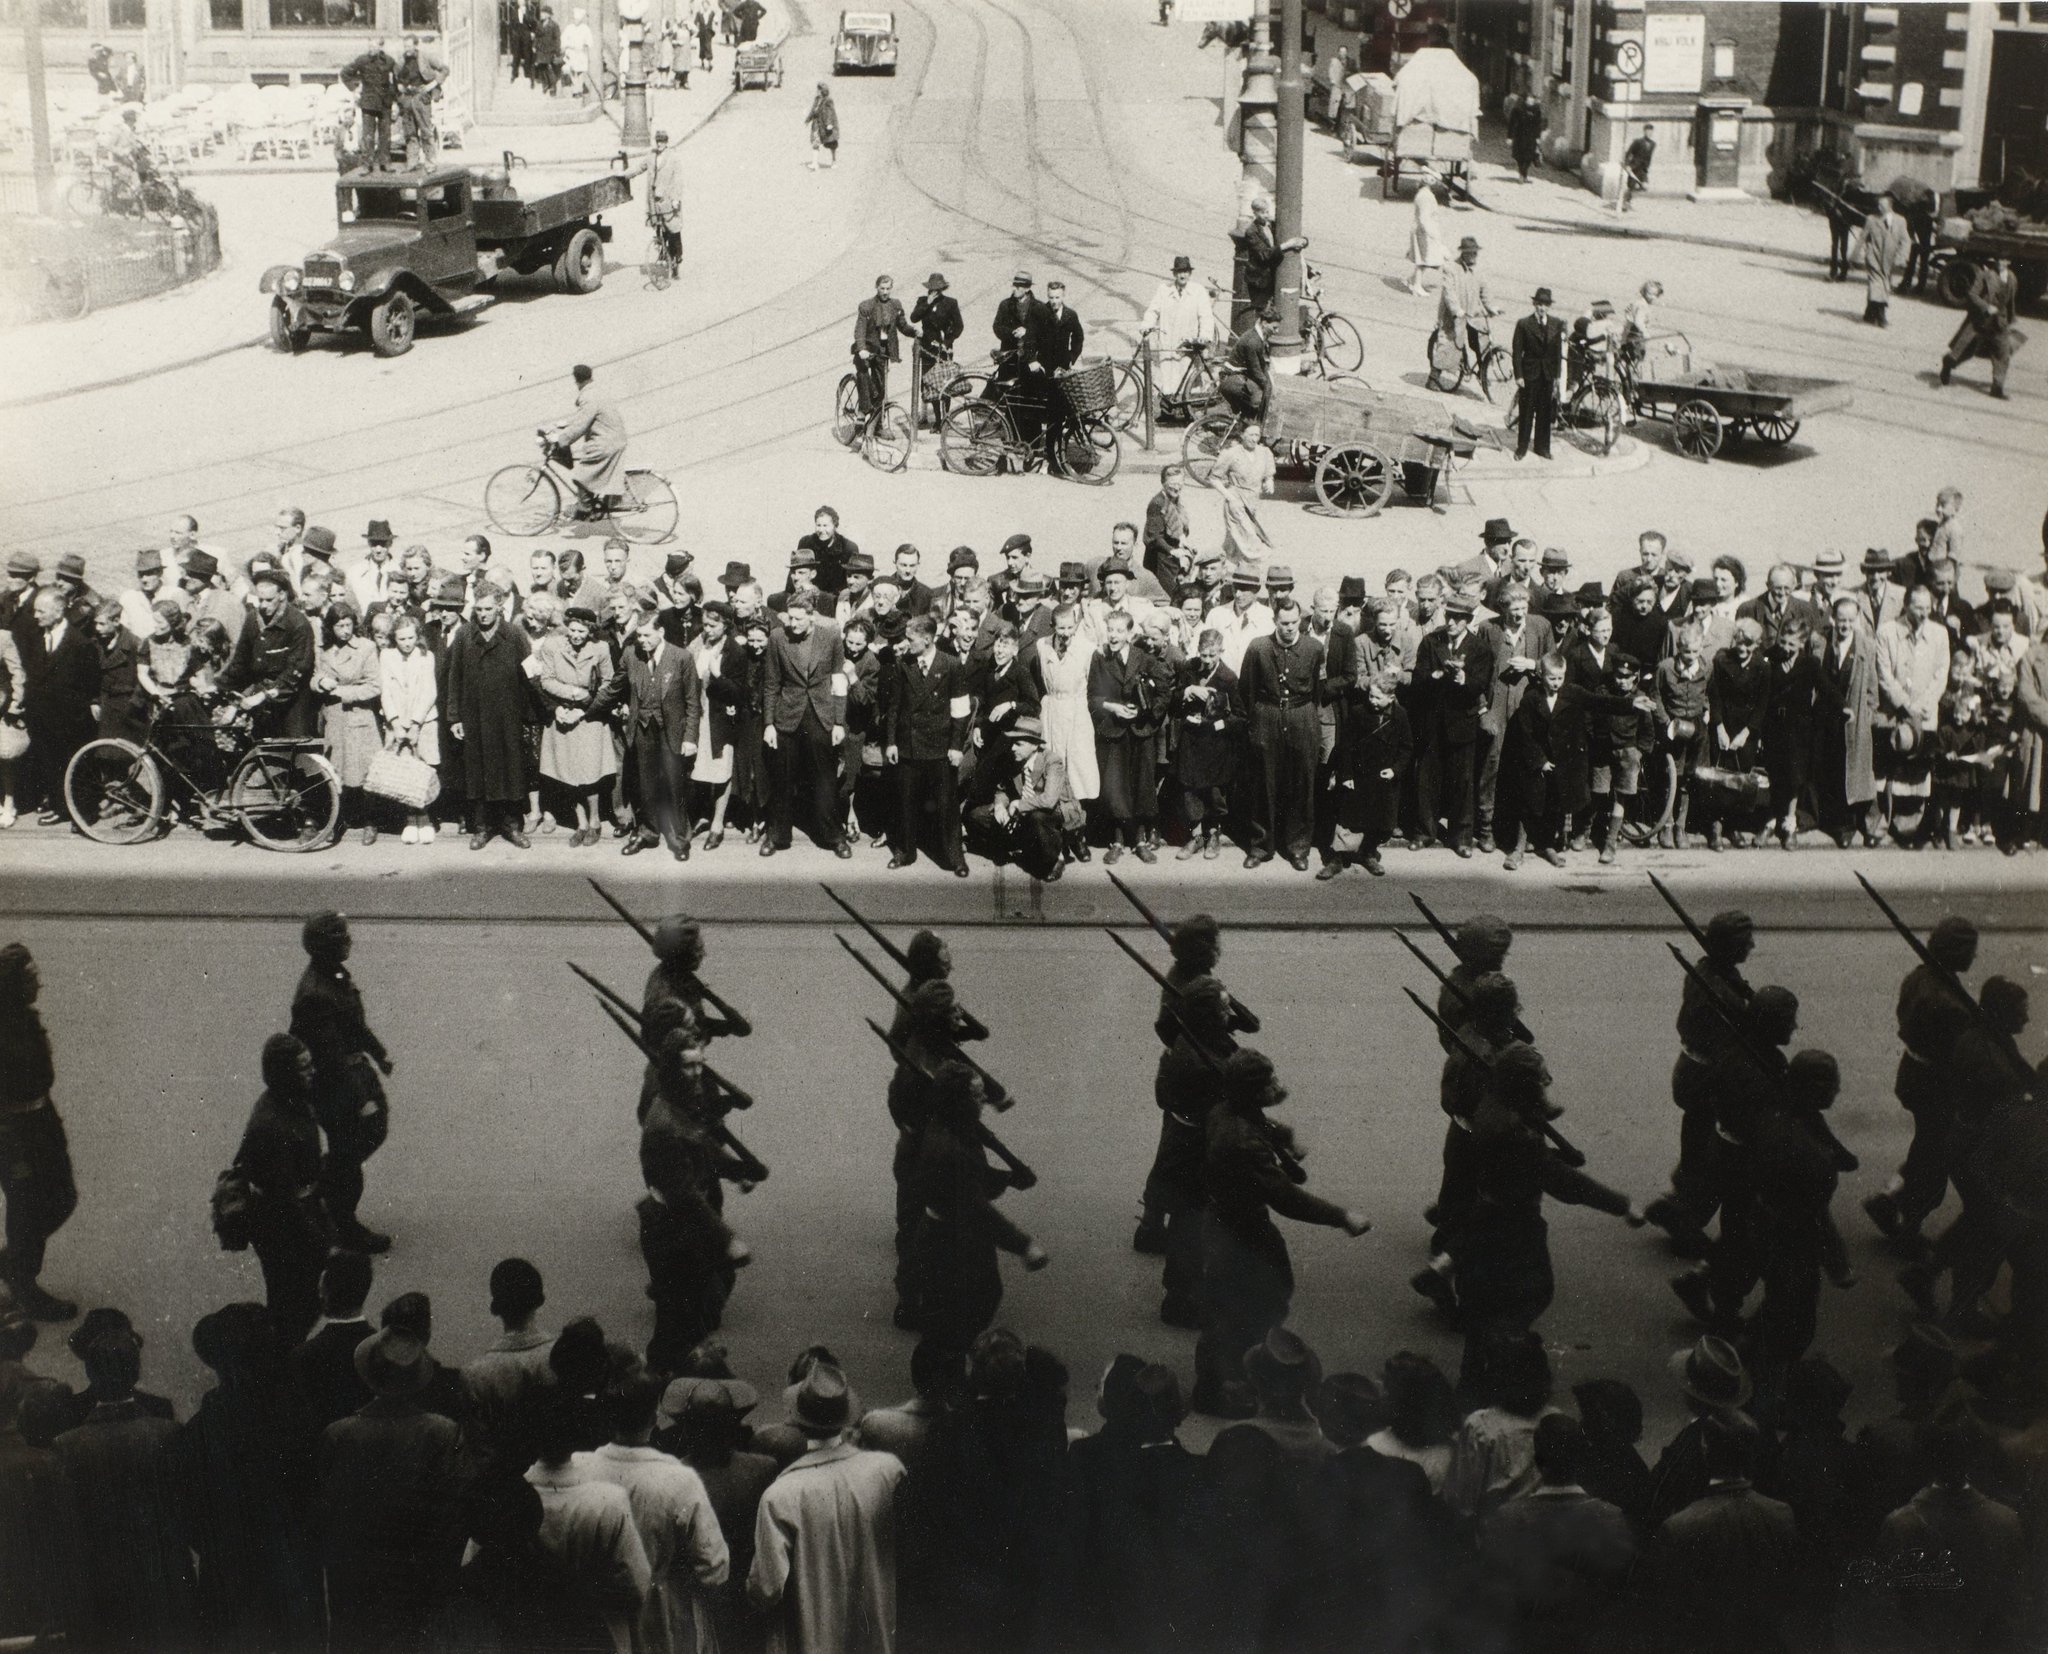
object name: photograph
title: Canadese militairen op het Leidseplein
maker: jacob merkelbach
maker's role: fotograaf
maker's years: 1877-1942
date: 1906-1945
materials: paper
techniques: photography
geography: amsterdam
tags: amsterdam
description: Naar rechts langstrekkende colonne van Canadese militairen te midden van publiek, op het Leidseplein te Amsterdam; foto vanuit Hirsch-gebouw genomen (atelier-Merkelbach) naar de Marnixstraat gezien.